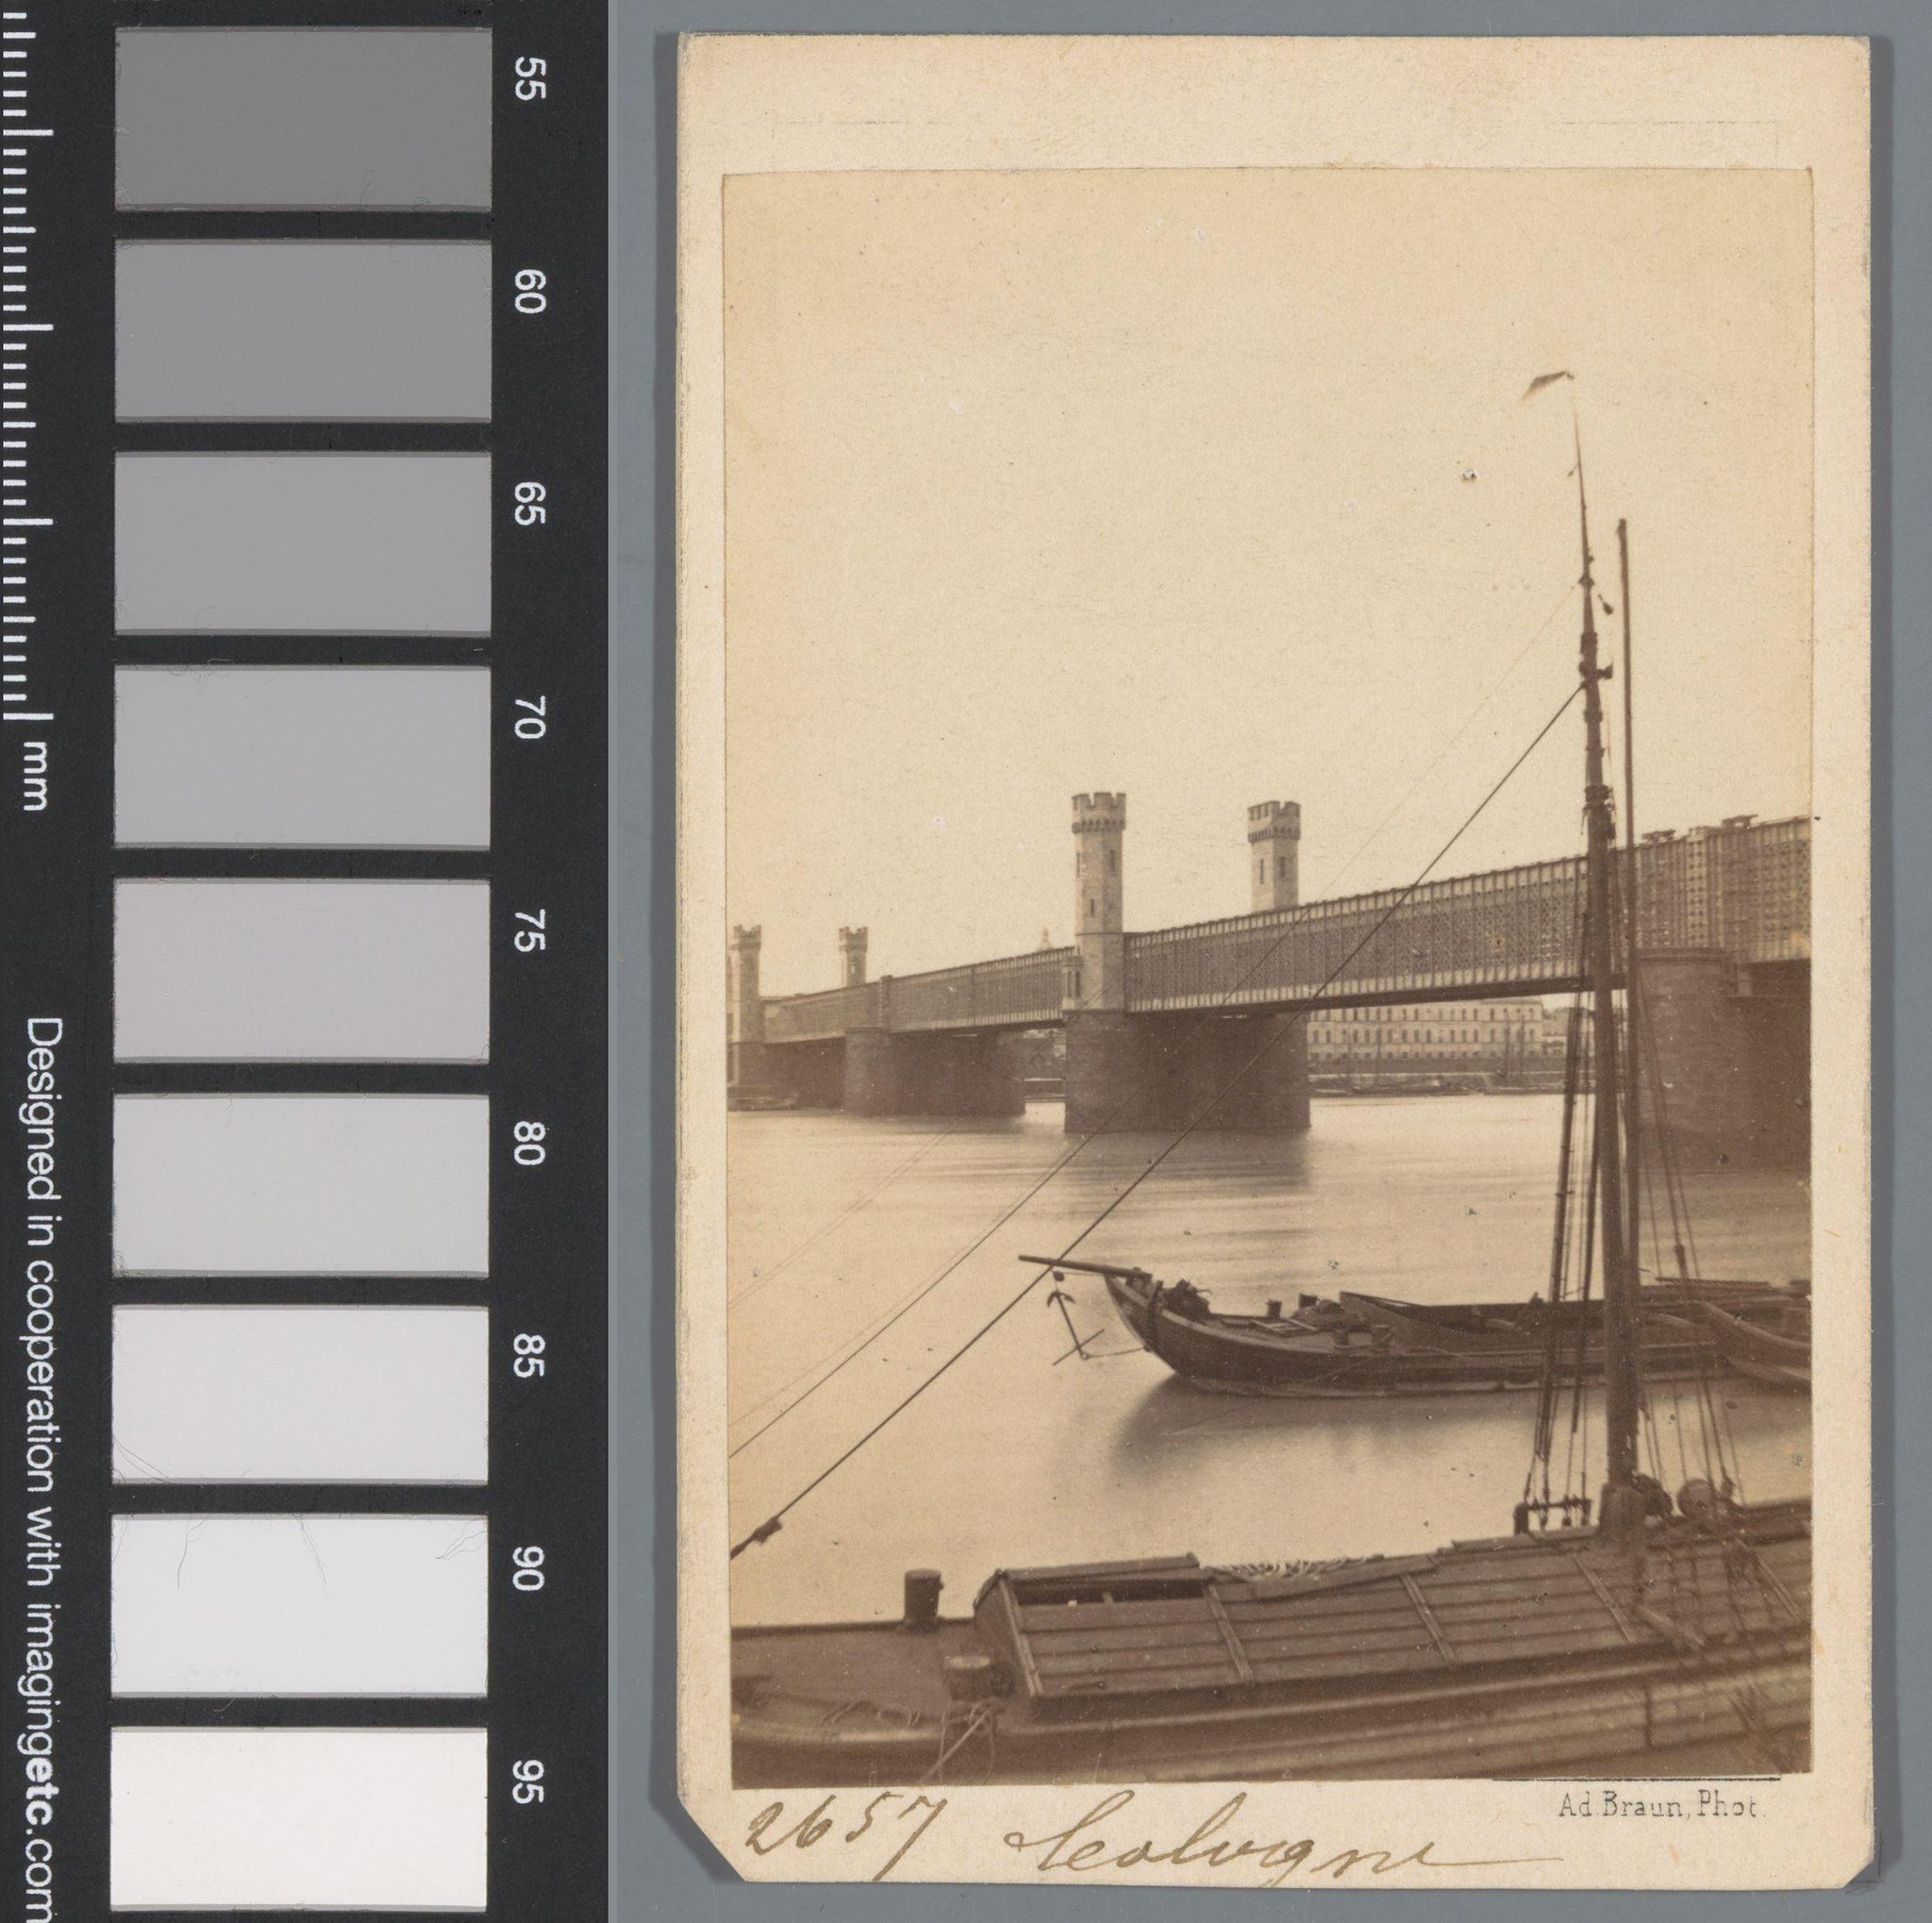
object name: photograph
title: Dombrücke in Keulen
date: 1859-1866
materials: cardboard, paper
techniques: albumen print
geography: cologne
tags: bridge in city across river, canal, etc.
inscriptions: number: ‘2657’, inscription: ‘AD. BRAUN./ PHOTOGRAPHE/ De S.M. L'EMPEREUR/ à Dornach. (Ht. Rhin)’